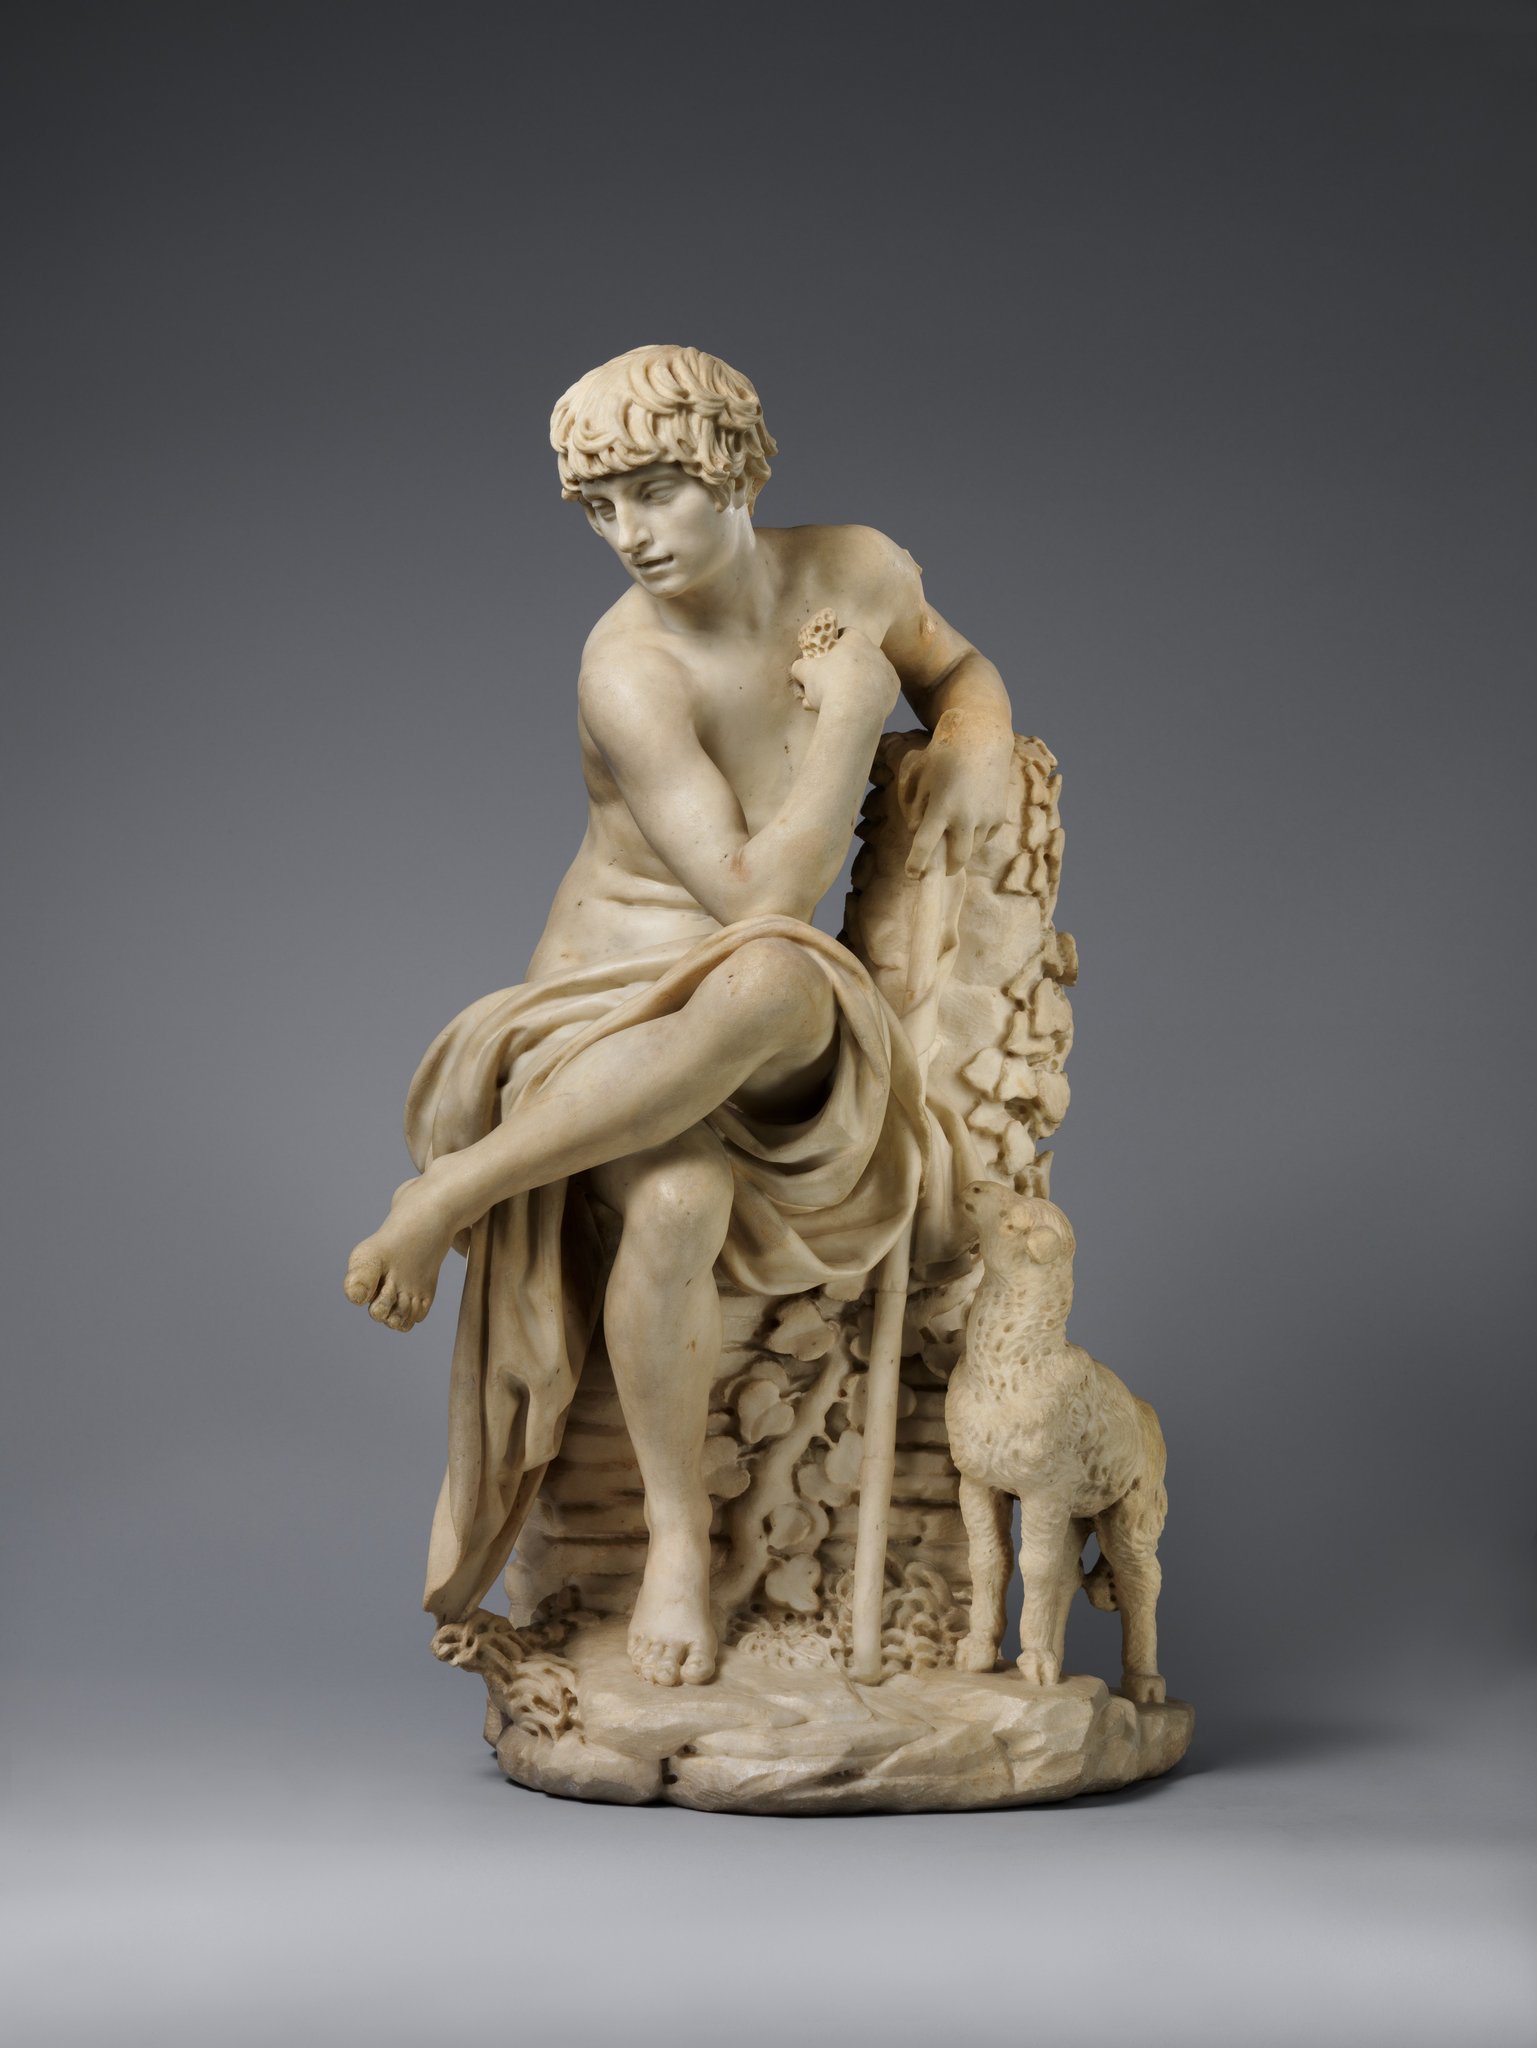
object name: statuette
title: The Youthful Saint John the Baptist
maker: domenico pieratti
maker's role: artist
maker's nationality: italian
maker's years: 1600-1656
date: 1625-1630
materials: marble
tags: sheep,saint john the baptist